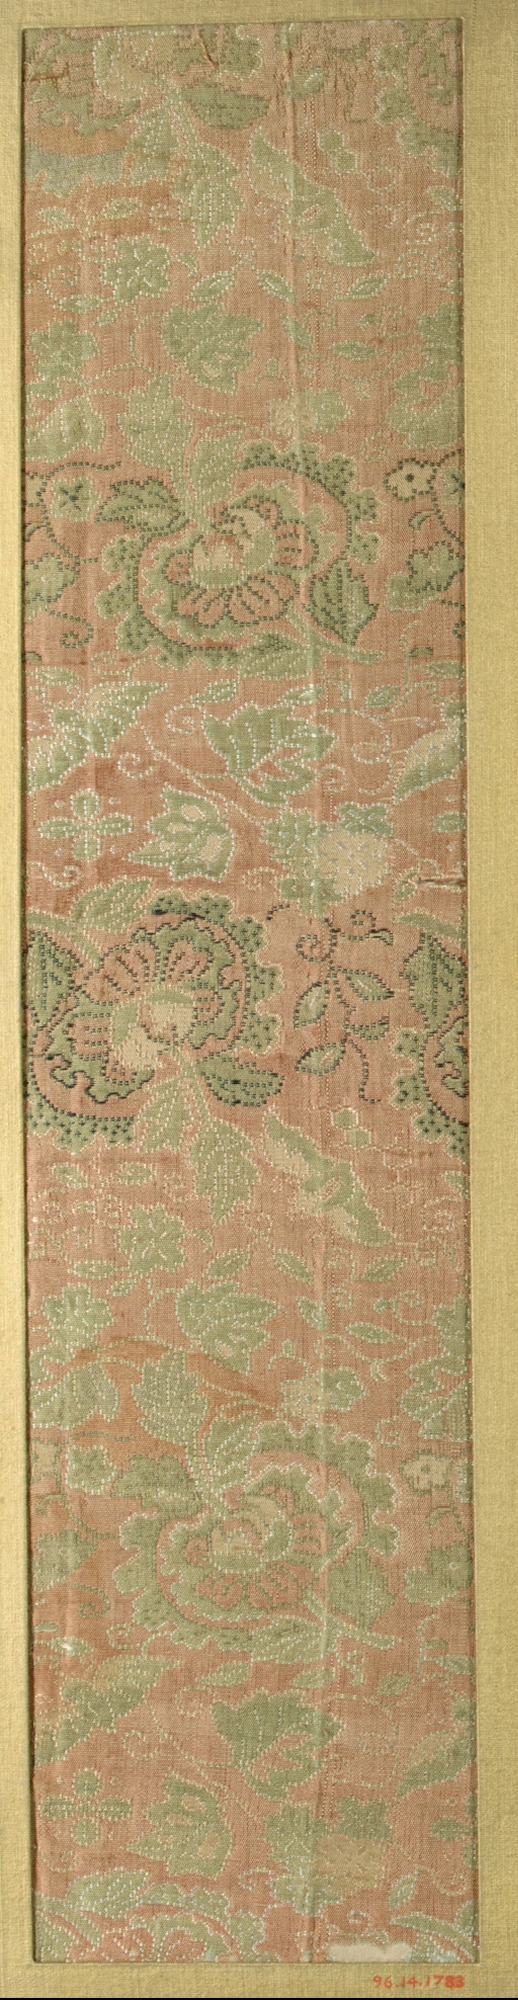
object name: piece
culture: japanese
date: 1701-1900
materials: silk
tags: flowers